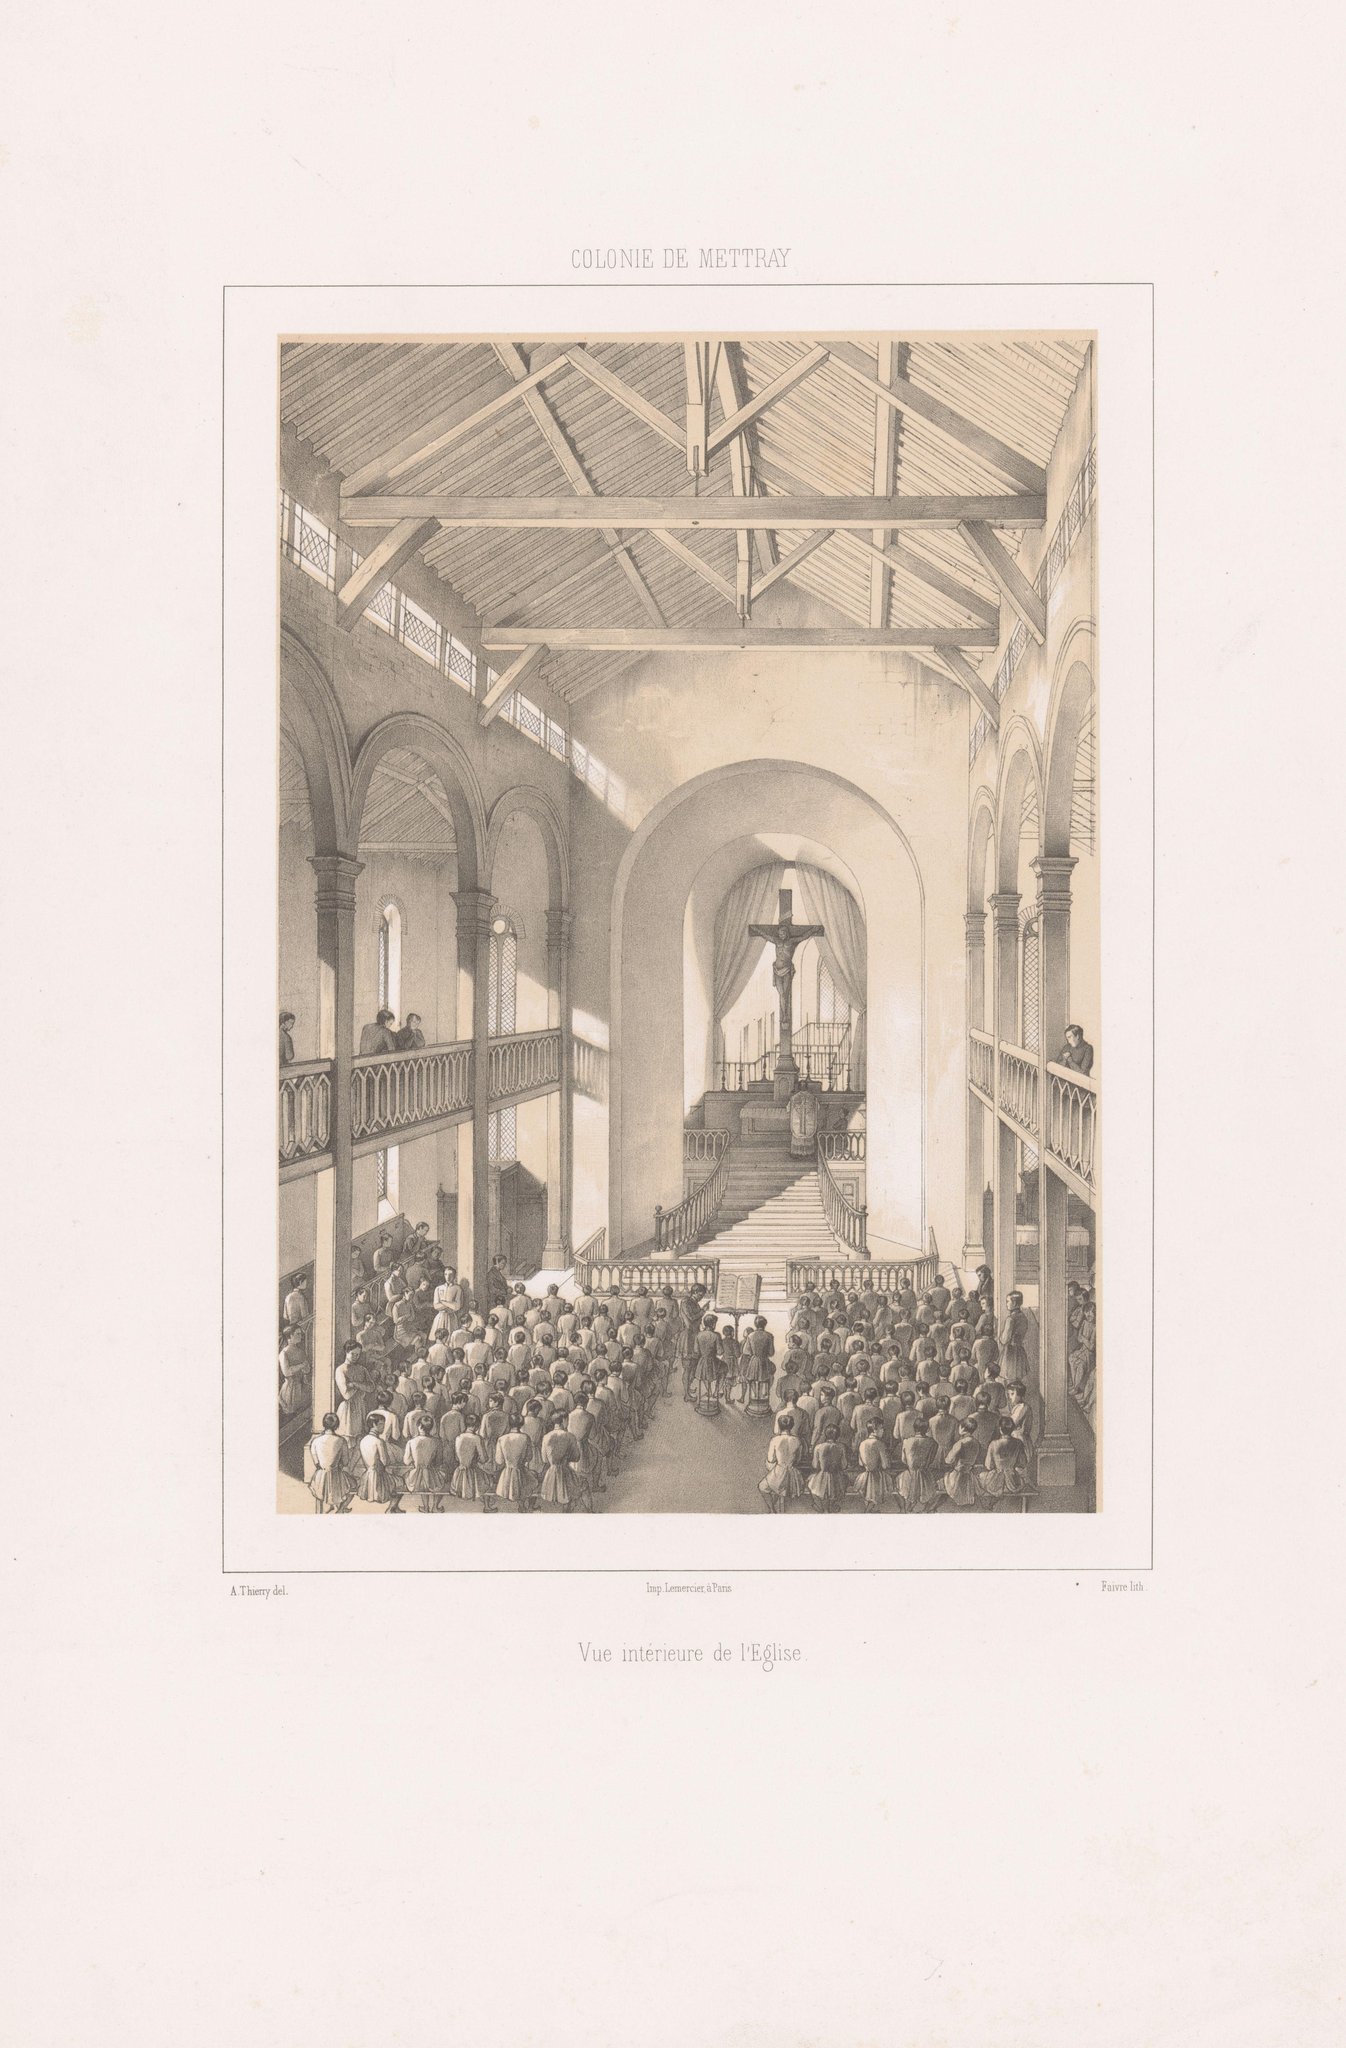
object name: print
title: Voorstellingen van de strafkolonie in Mettray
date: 1844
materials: paper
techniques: tone lithography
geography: paris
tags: interior of church, workhouse, penal camp, penitentiary, chain gang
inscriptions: collector's mark: Lugt 2228a